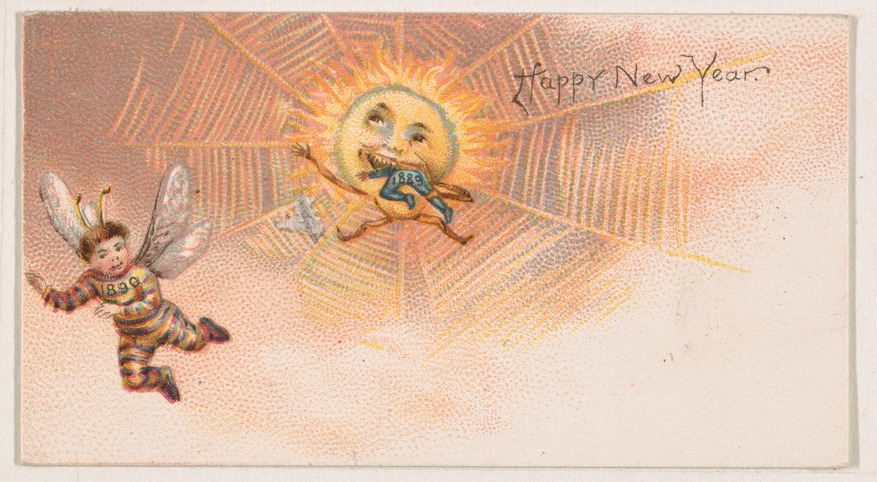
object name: print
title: Happy New Year, from the New Years 1890 series (N227) issued by Kinney Bros.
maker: kinney brothers tobacco company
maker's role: publisher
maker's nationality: american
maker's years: 1869-2011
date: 1889-1890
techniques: color lithograph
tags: sun